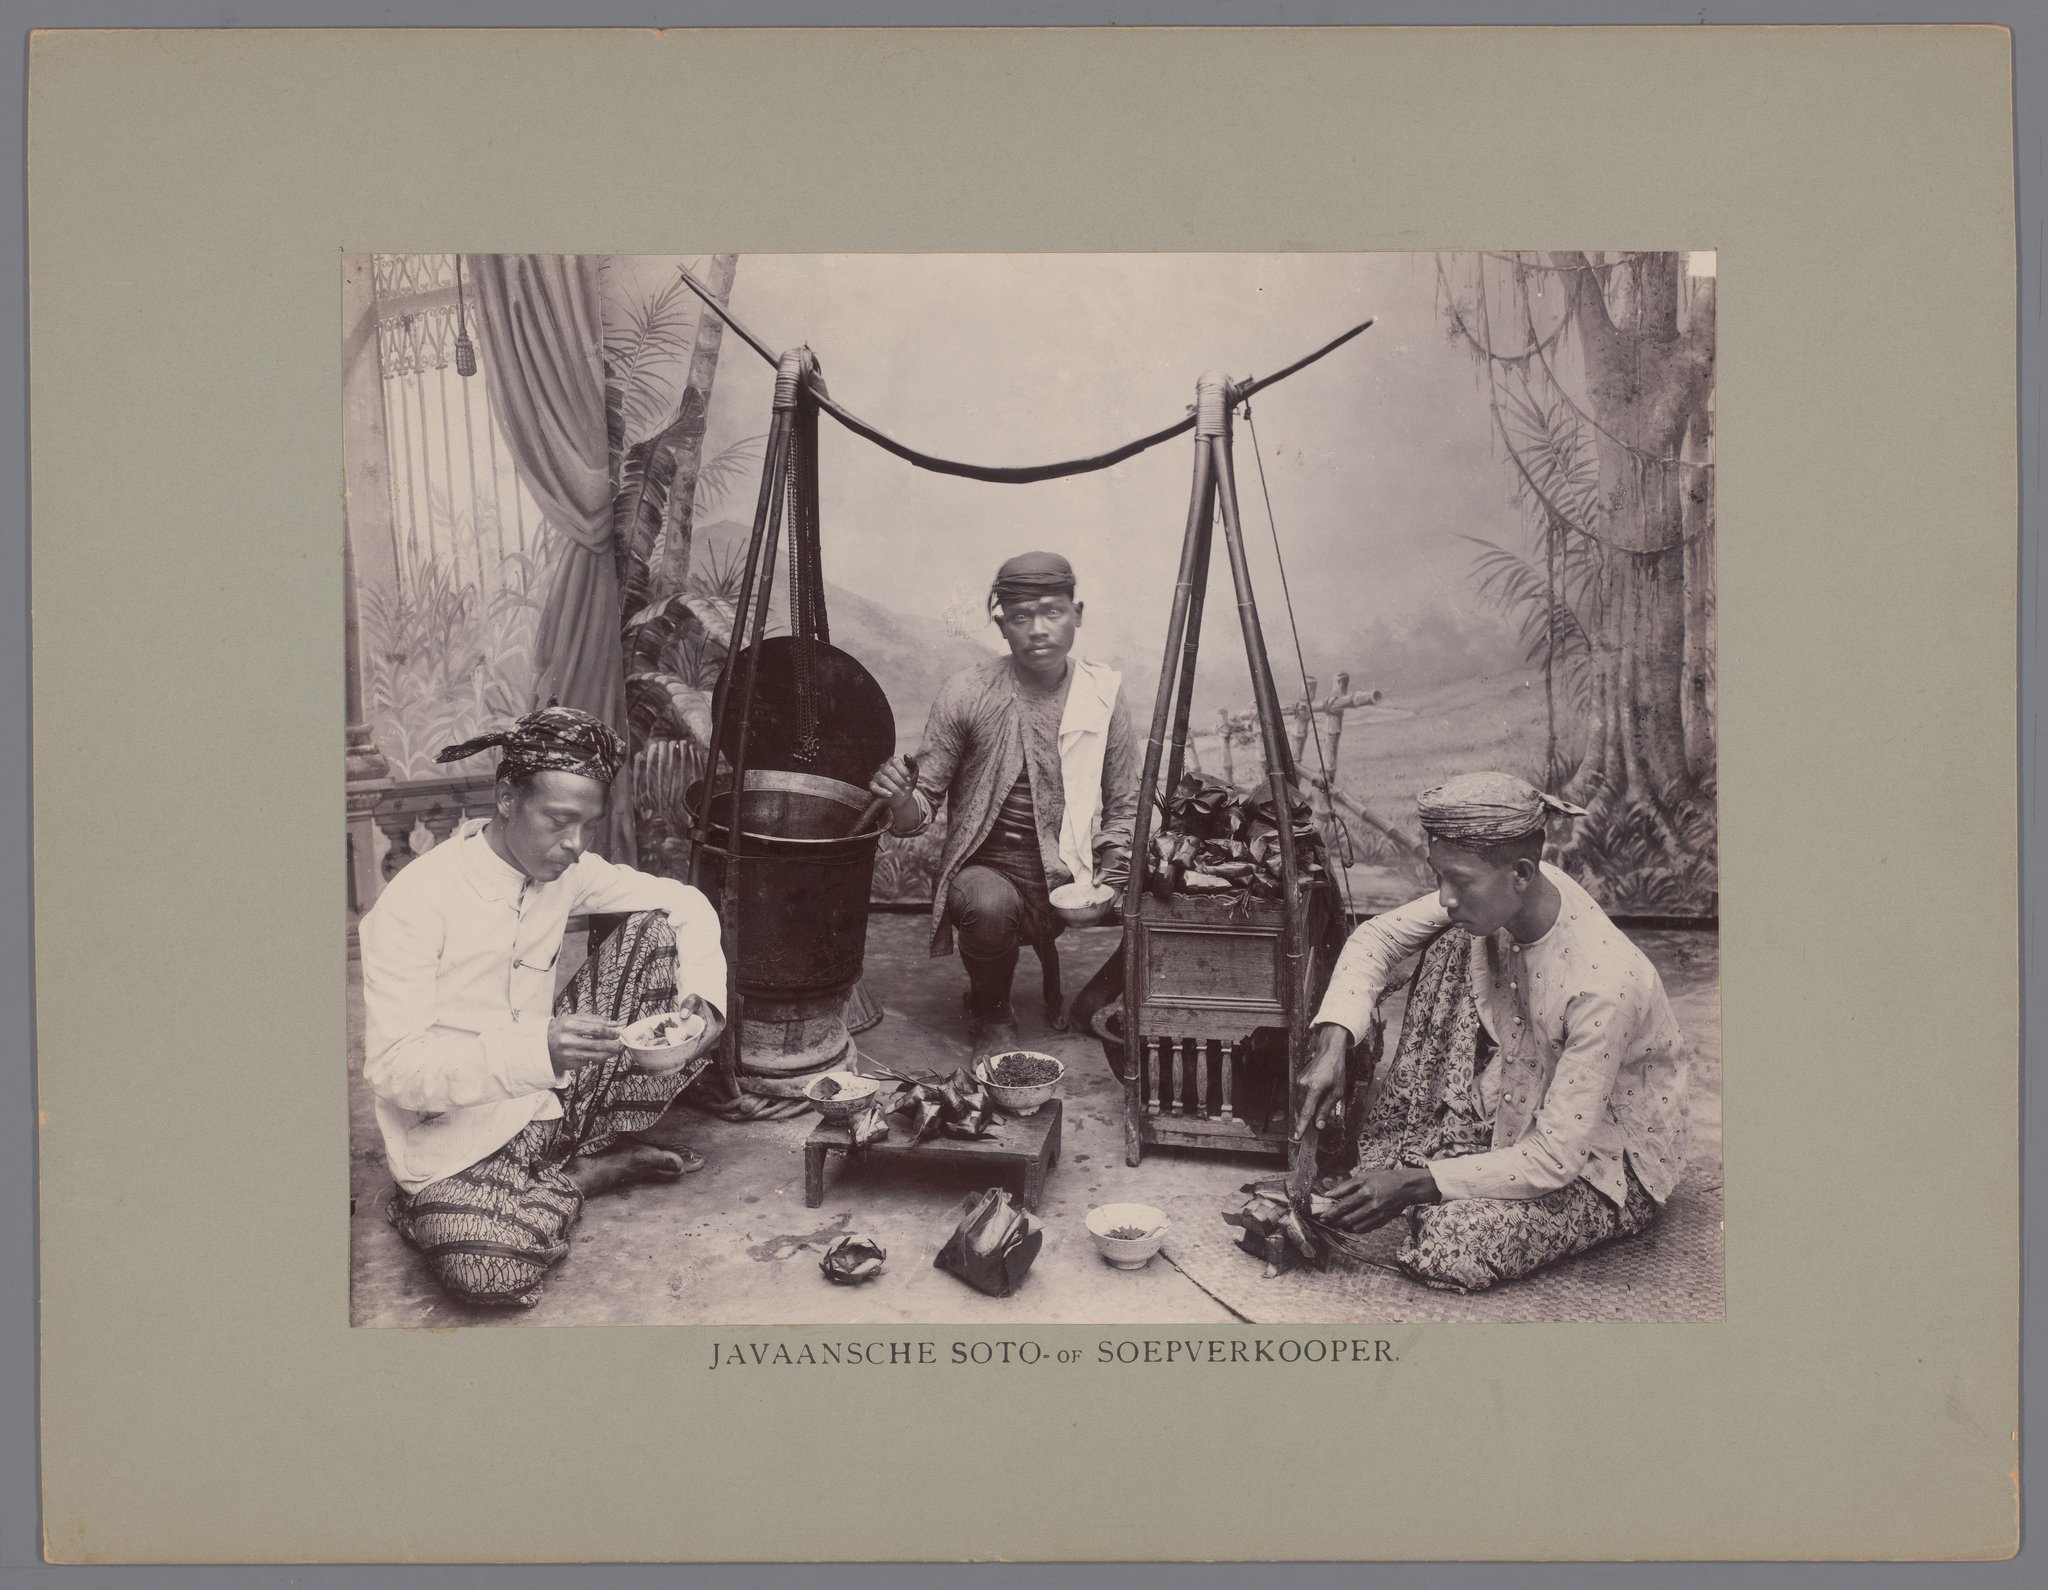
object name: photograph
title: Javaanse Soto- of soepverkoper, Nederlands-Indië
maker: Anonymous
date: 1900-1925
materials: cardboard, photographic support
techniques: gelatin silver print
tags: dutch east indies, the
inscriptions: number: ‘1313’, caption: ‘JAVAANSCHE SOTO- OF SOEPVERKOOPER.’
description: Gezelschap van drie hurkende of zittende Javaanse mannen met doeken om hun hoofd genknoopt. De mannen links en rechts bereiden het een en ander voor aan een klein tafeltje waarop bakjes staan met ingrediënten, terwijl de man in het midden in de pan roert. Hij kijkt in de camera. De setting betreft een fotostudio, gezien de geschilderde achtergrond.